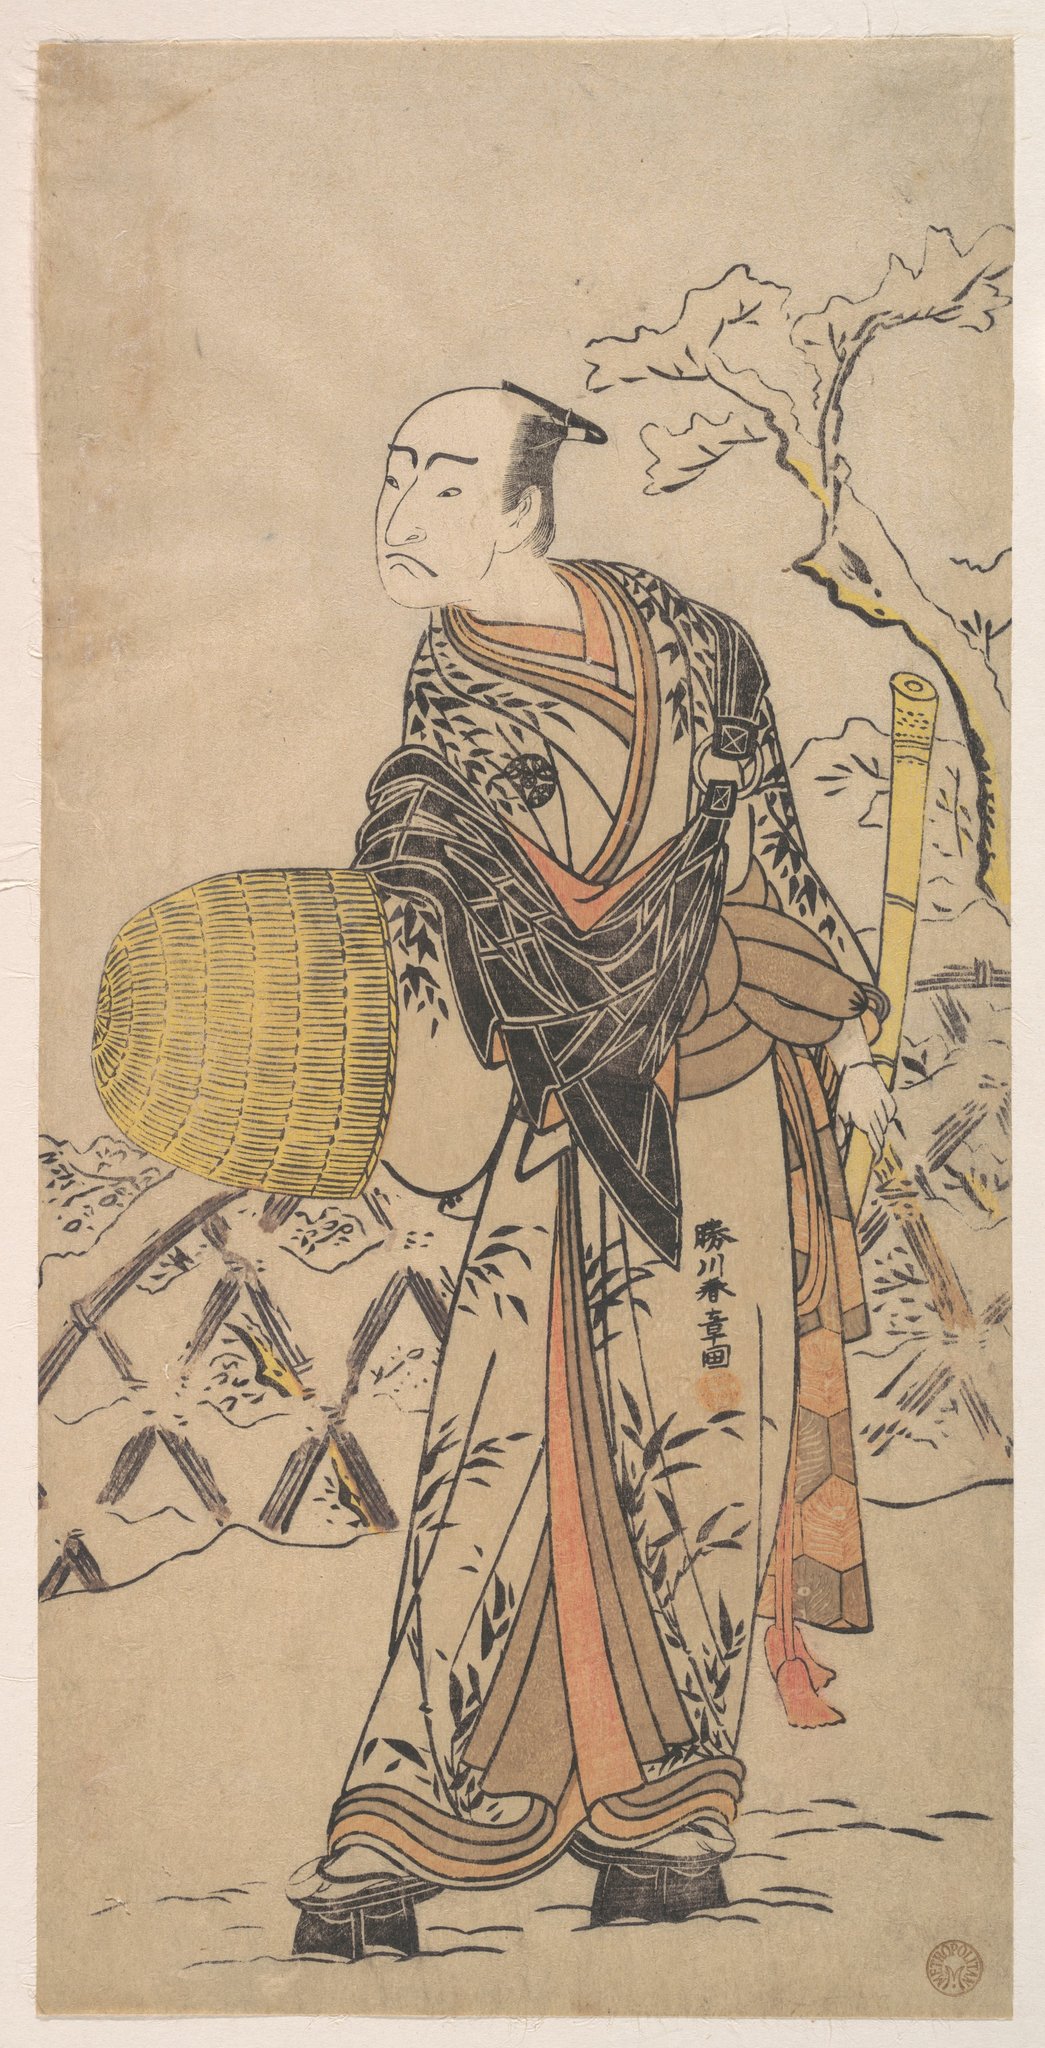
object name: woodblock print nishiki e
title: The First Nakamura Nakazo as a Komuso Standing in the Snow by a Fence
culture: japanese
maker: katsukawa shunshō 勝川春章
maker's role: artist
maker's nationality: japanese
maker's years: 1726-1792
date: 1775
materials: ink, paper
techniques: nishiki e, woodblock print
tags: men,actors